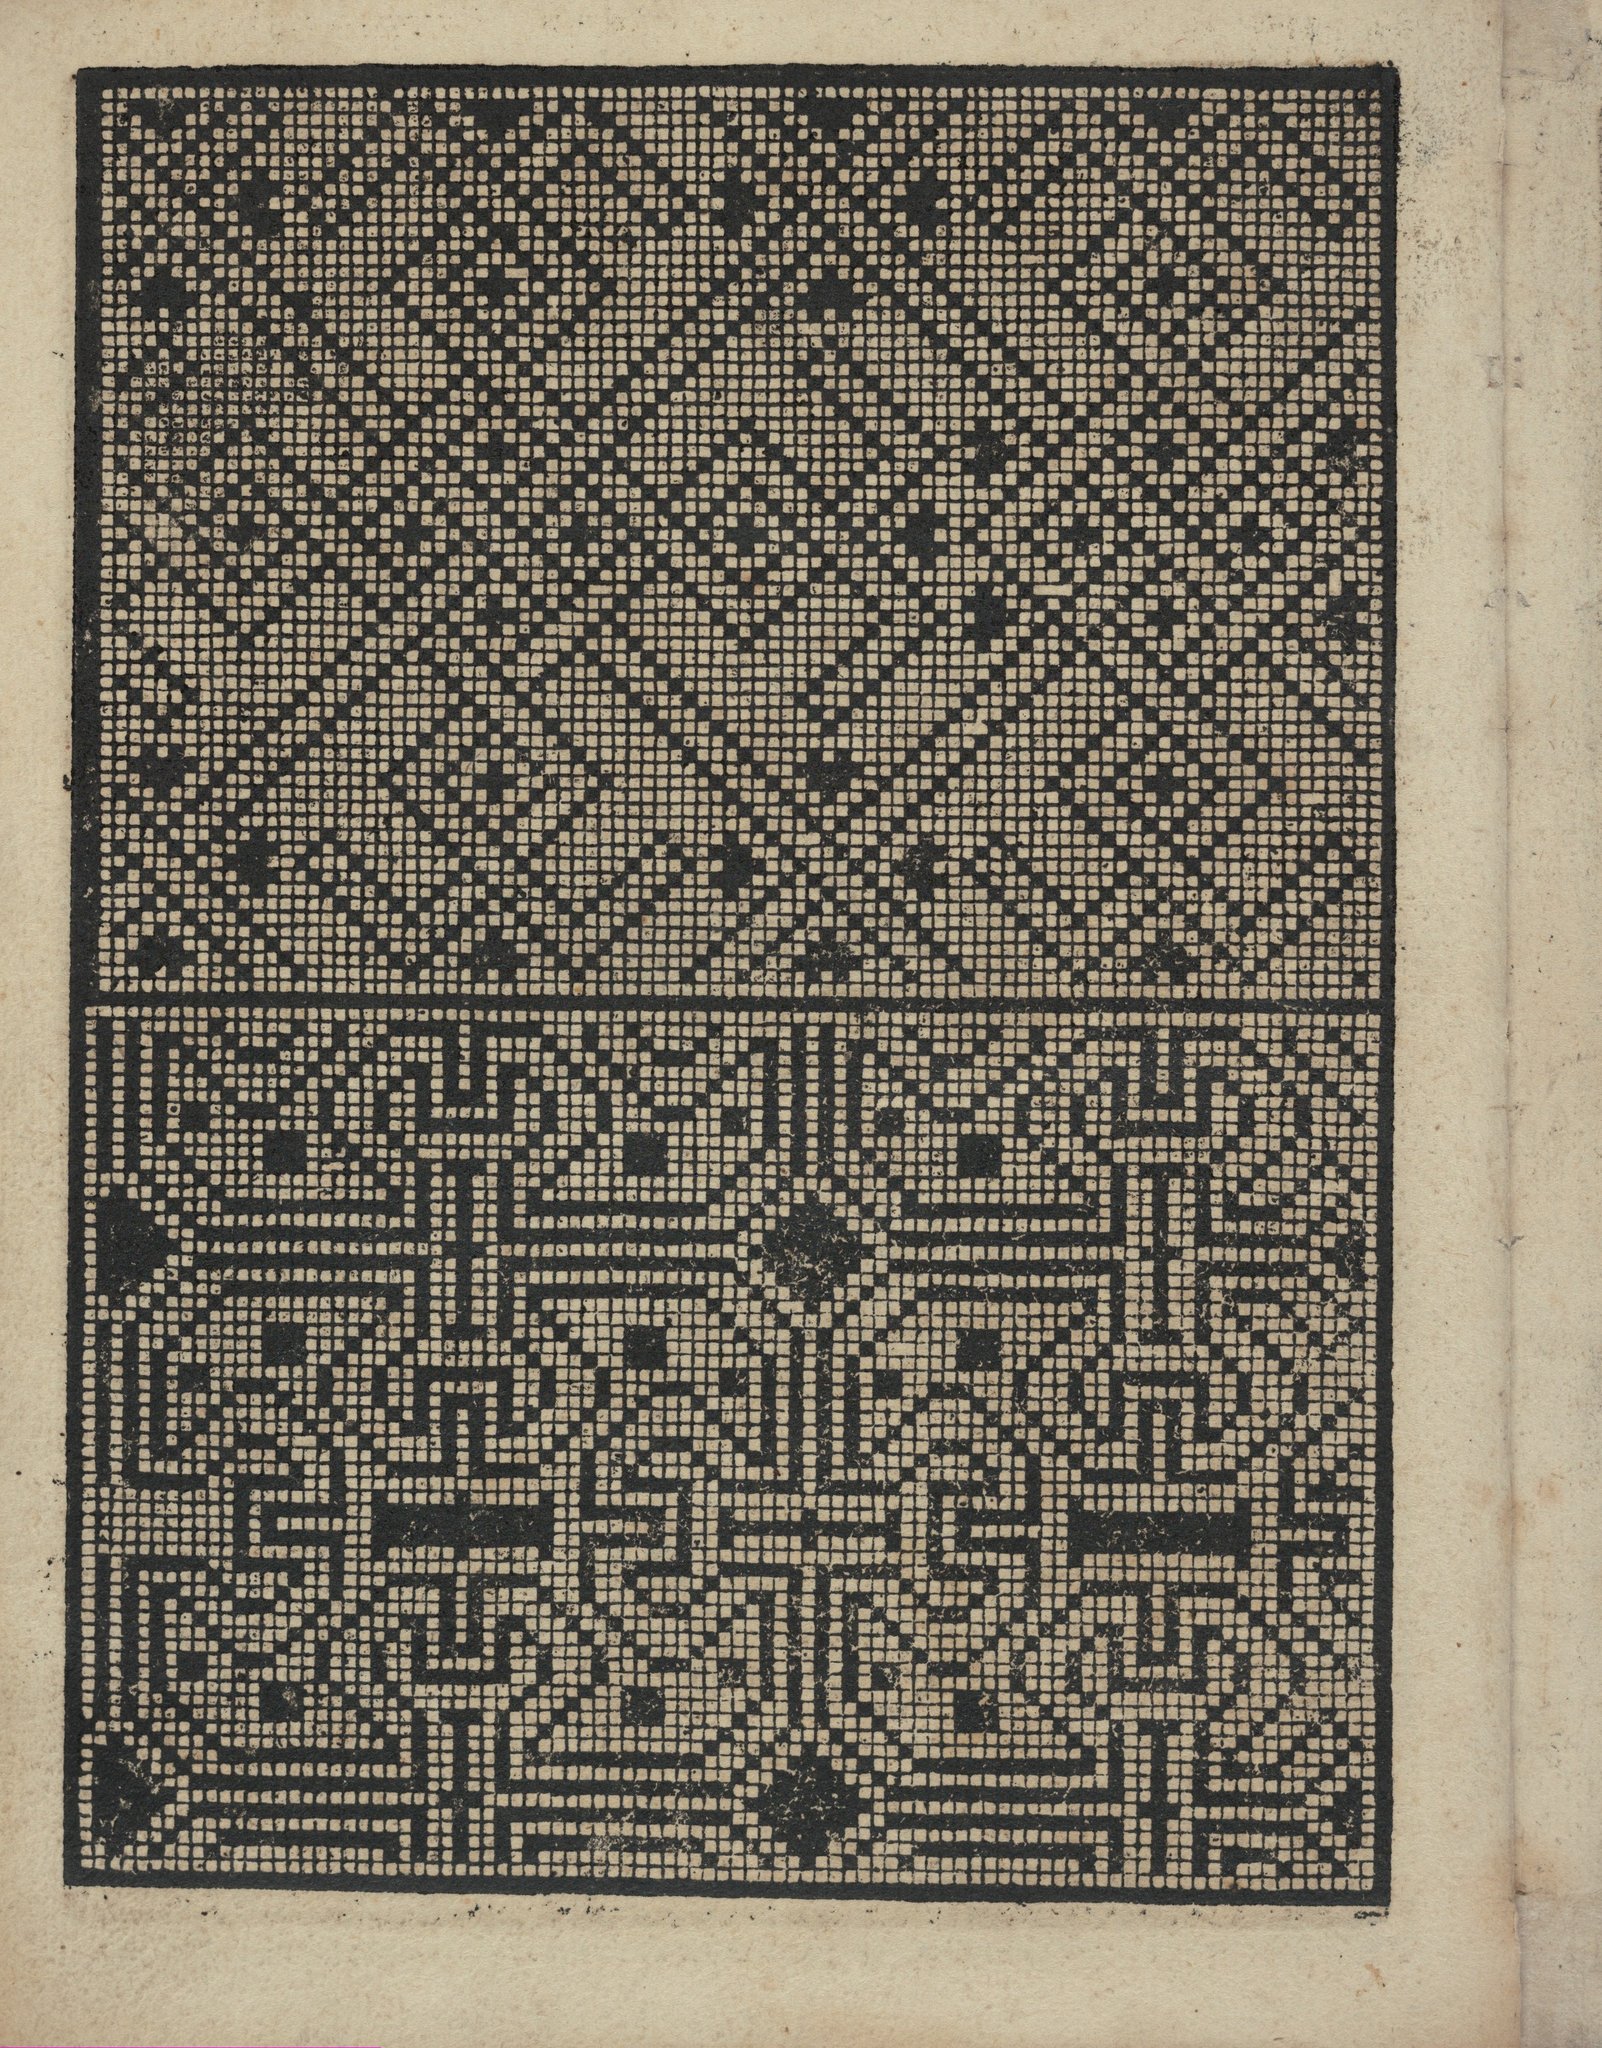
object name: book print ornament architecture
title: Libbretto nouellamete composto per maestro Domenico da Sera...lauorare di ogni sorte di punti, page 15 (verso)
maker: domenico da sera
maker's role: publisher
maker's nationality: french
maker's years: 1500-1599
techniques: woodcut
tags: ornament